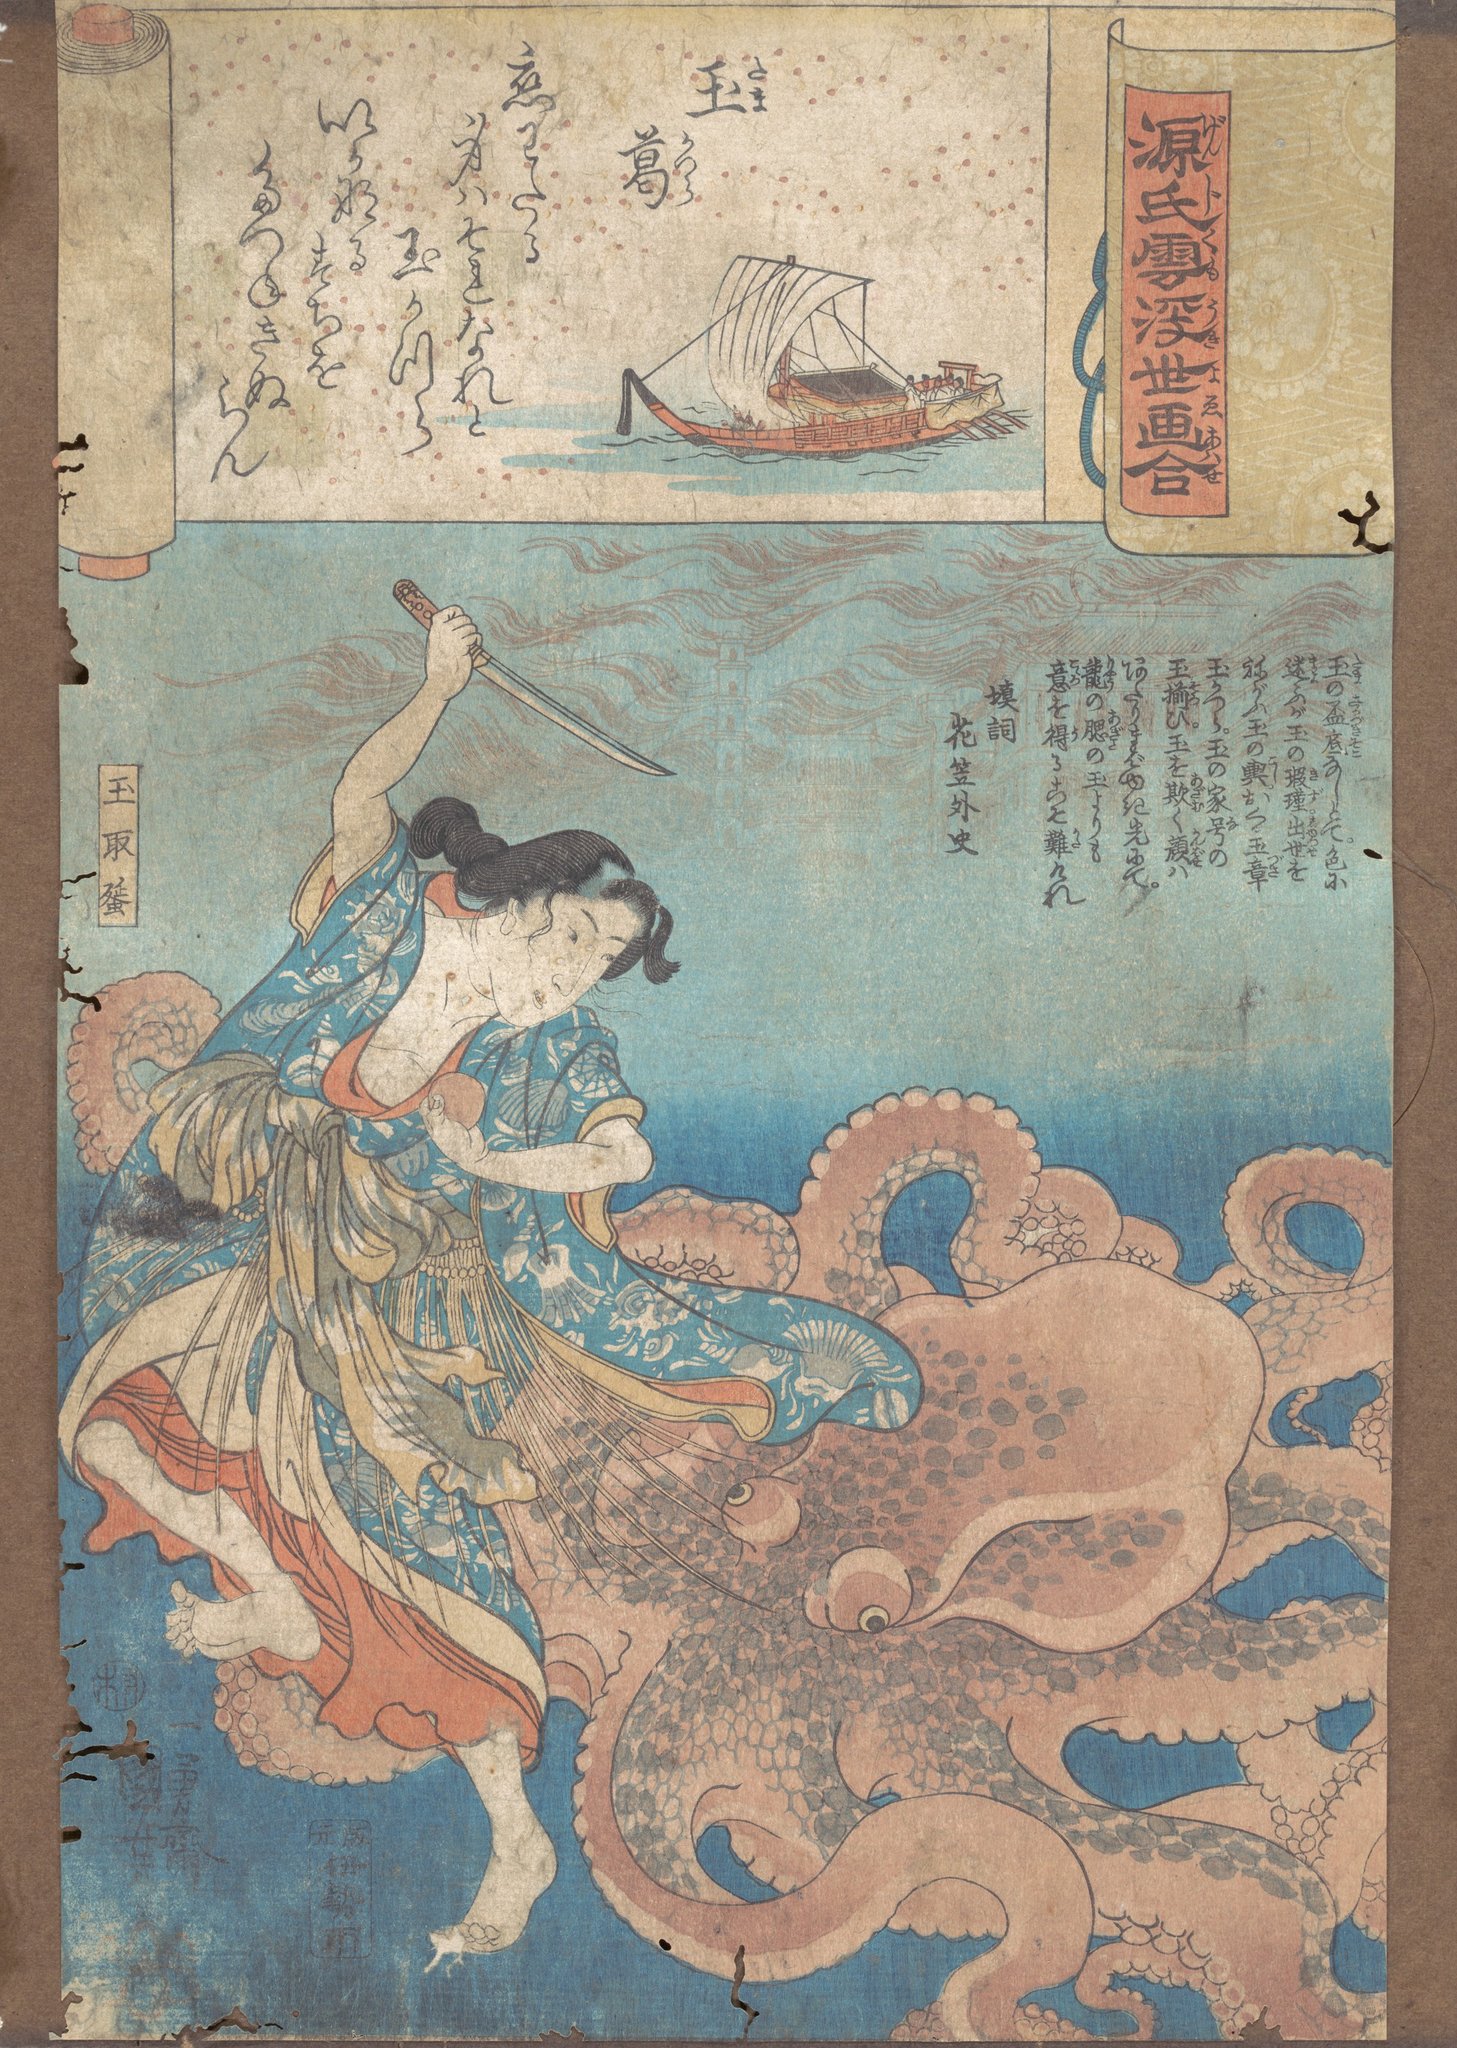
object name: print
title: The Jeweled Chaplet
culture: japanese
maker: utagawa kuniyoshi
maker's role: artist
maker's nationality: japanese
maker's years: 1797-1861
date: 1845-1846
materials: ink, paper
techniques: woodblock print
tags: women,octopus,boats